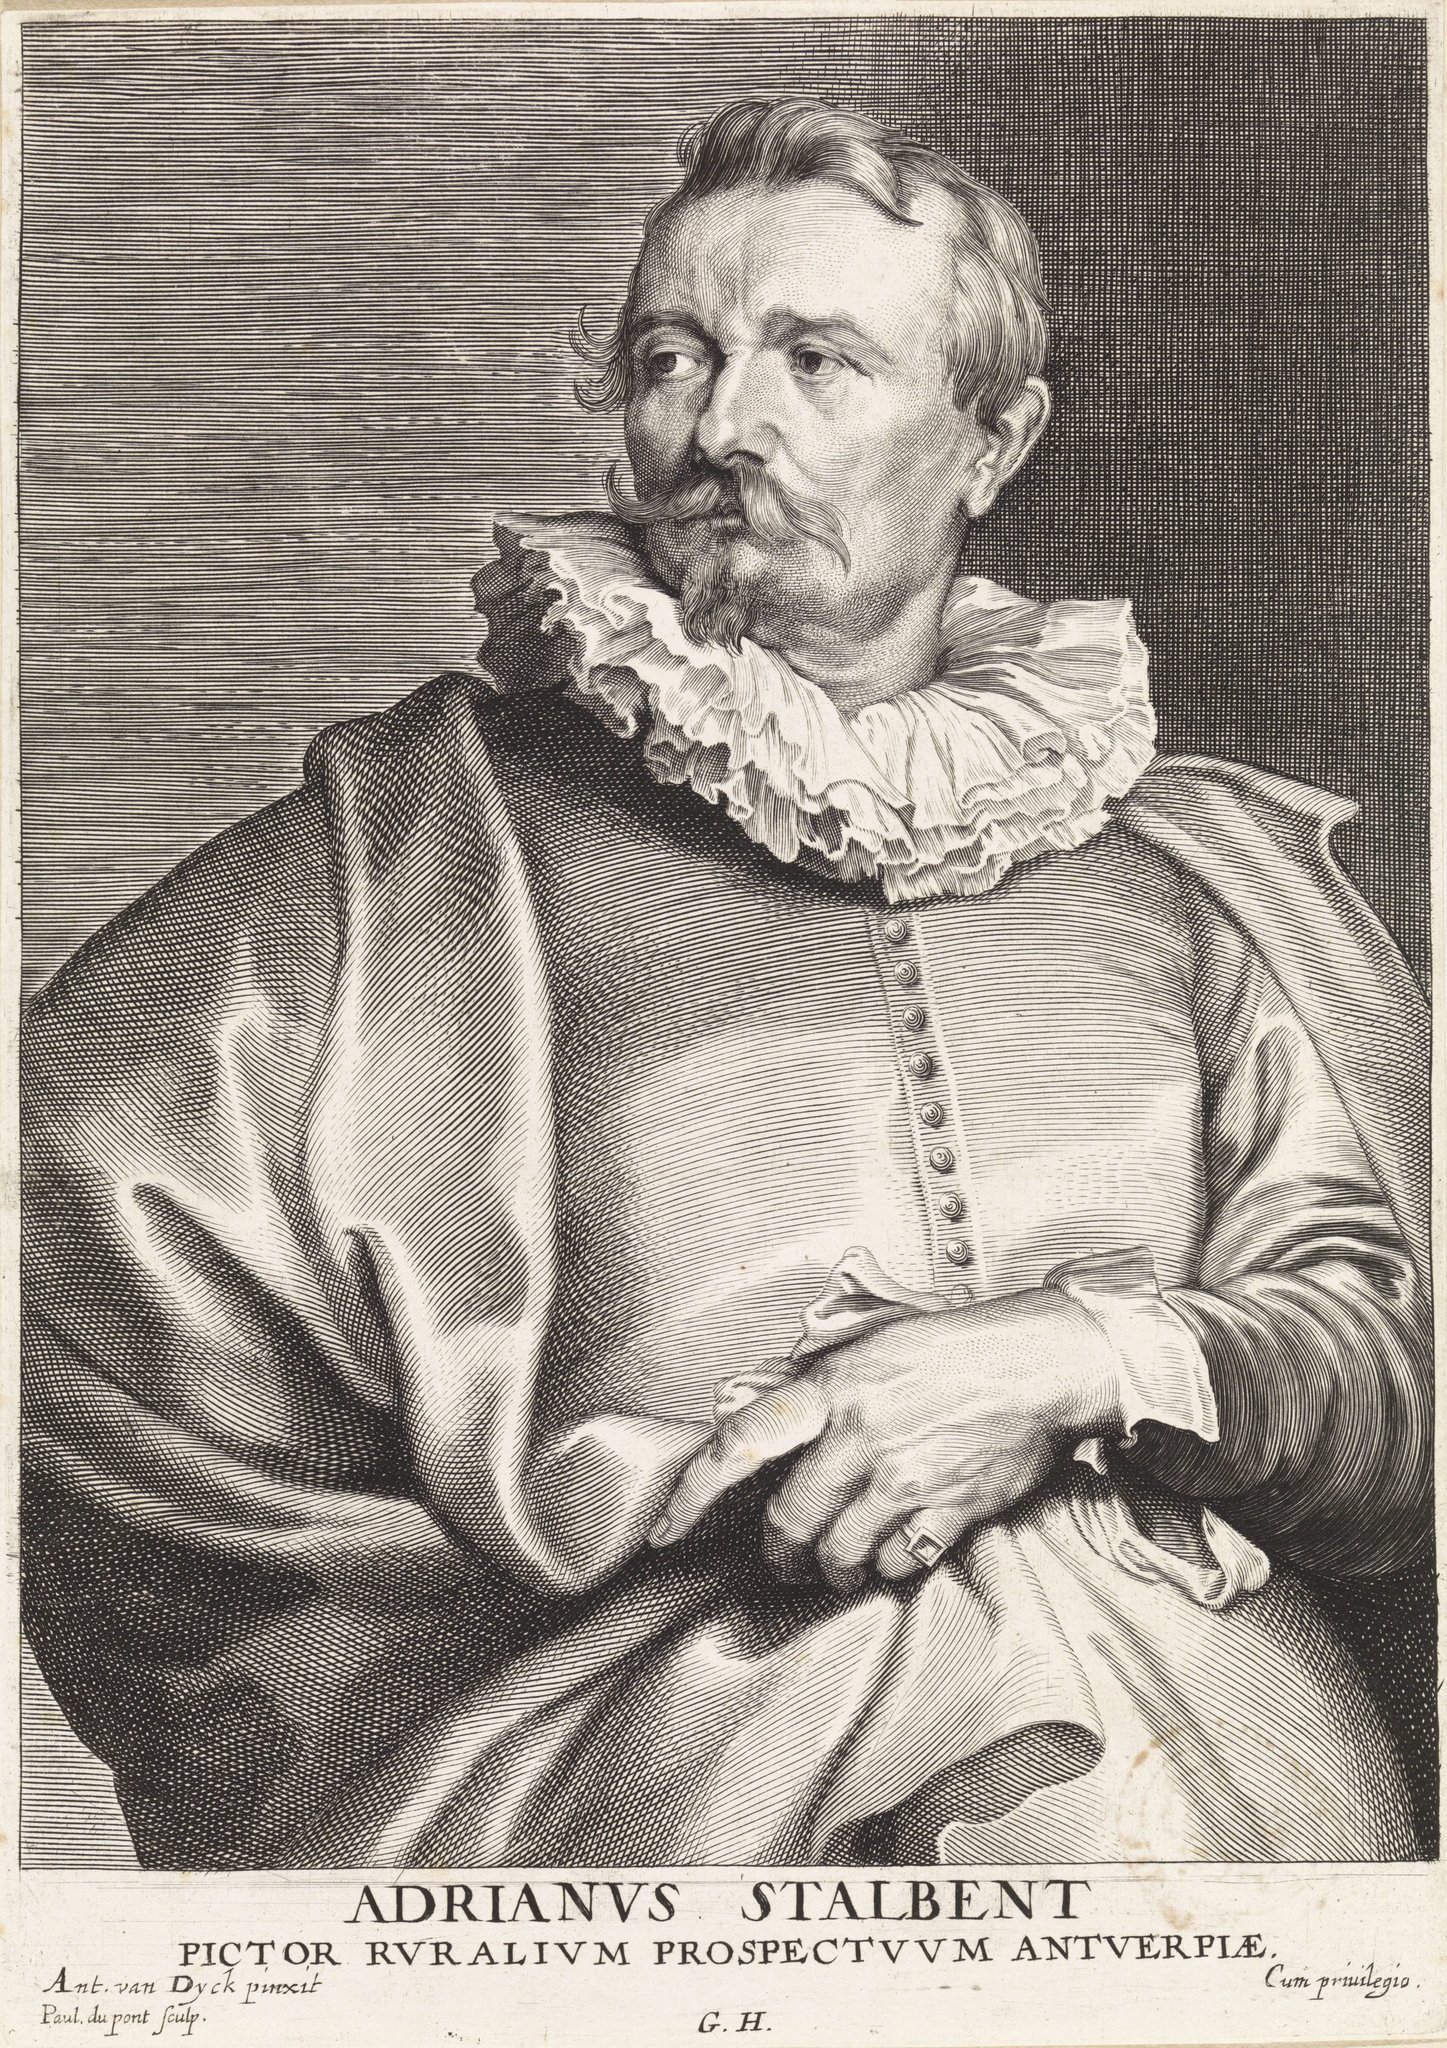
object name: print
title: Portret van de schilder Adriaen van Stalbemt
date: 1616-1657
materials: paper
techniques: engraving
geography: antwerp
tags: antwerp, painter, print maker, adriaen van stalbemt, portrait, self-portrait of painter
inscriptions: collector's mark: Lugt 240